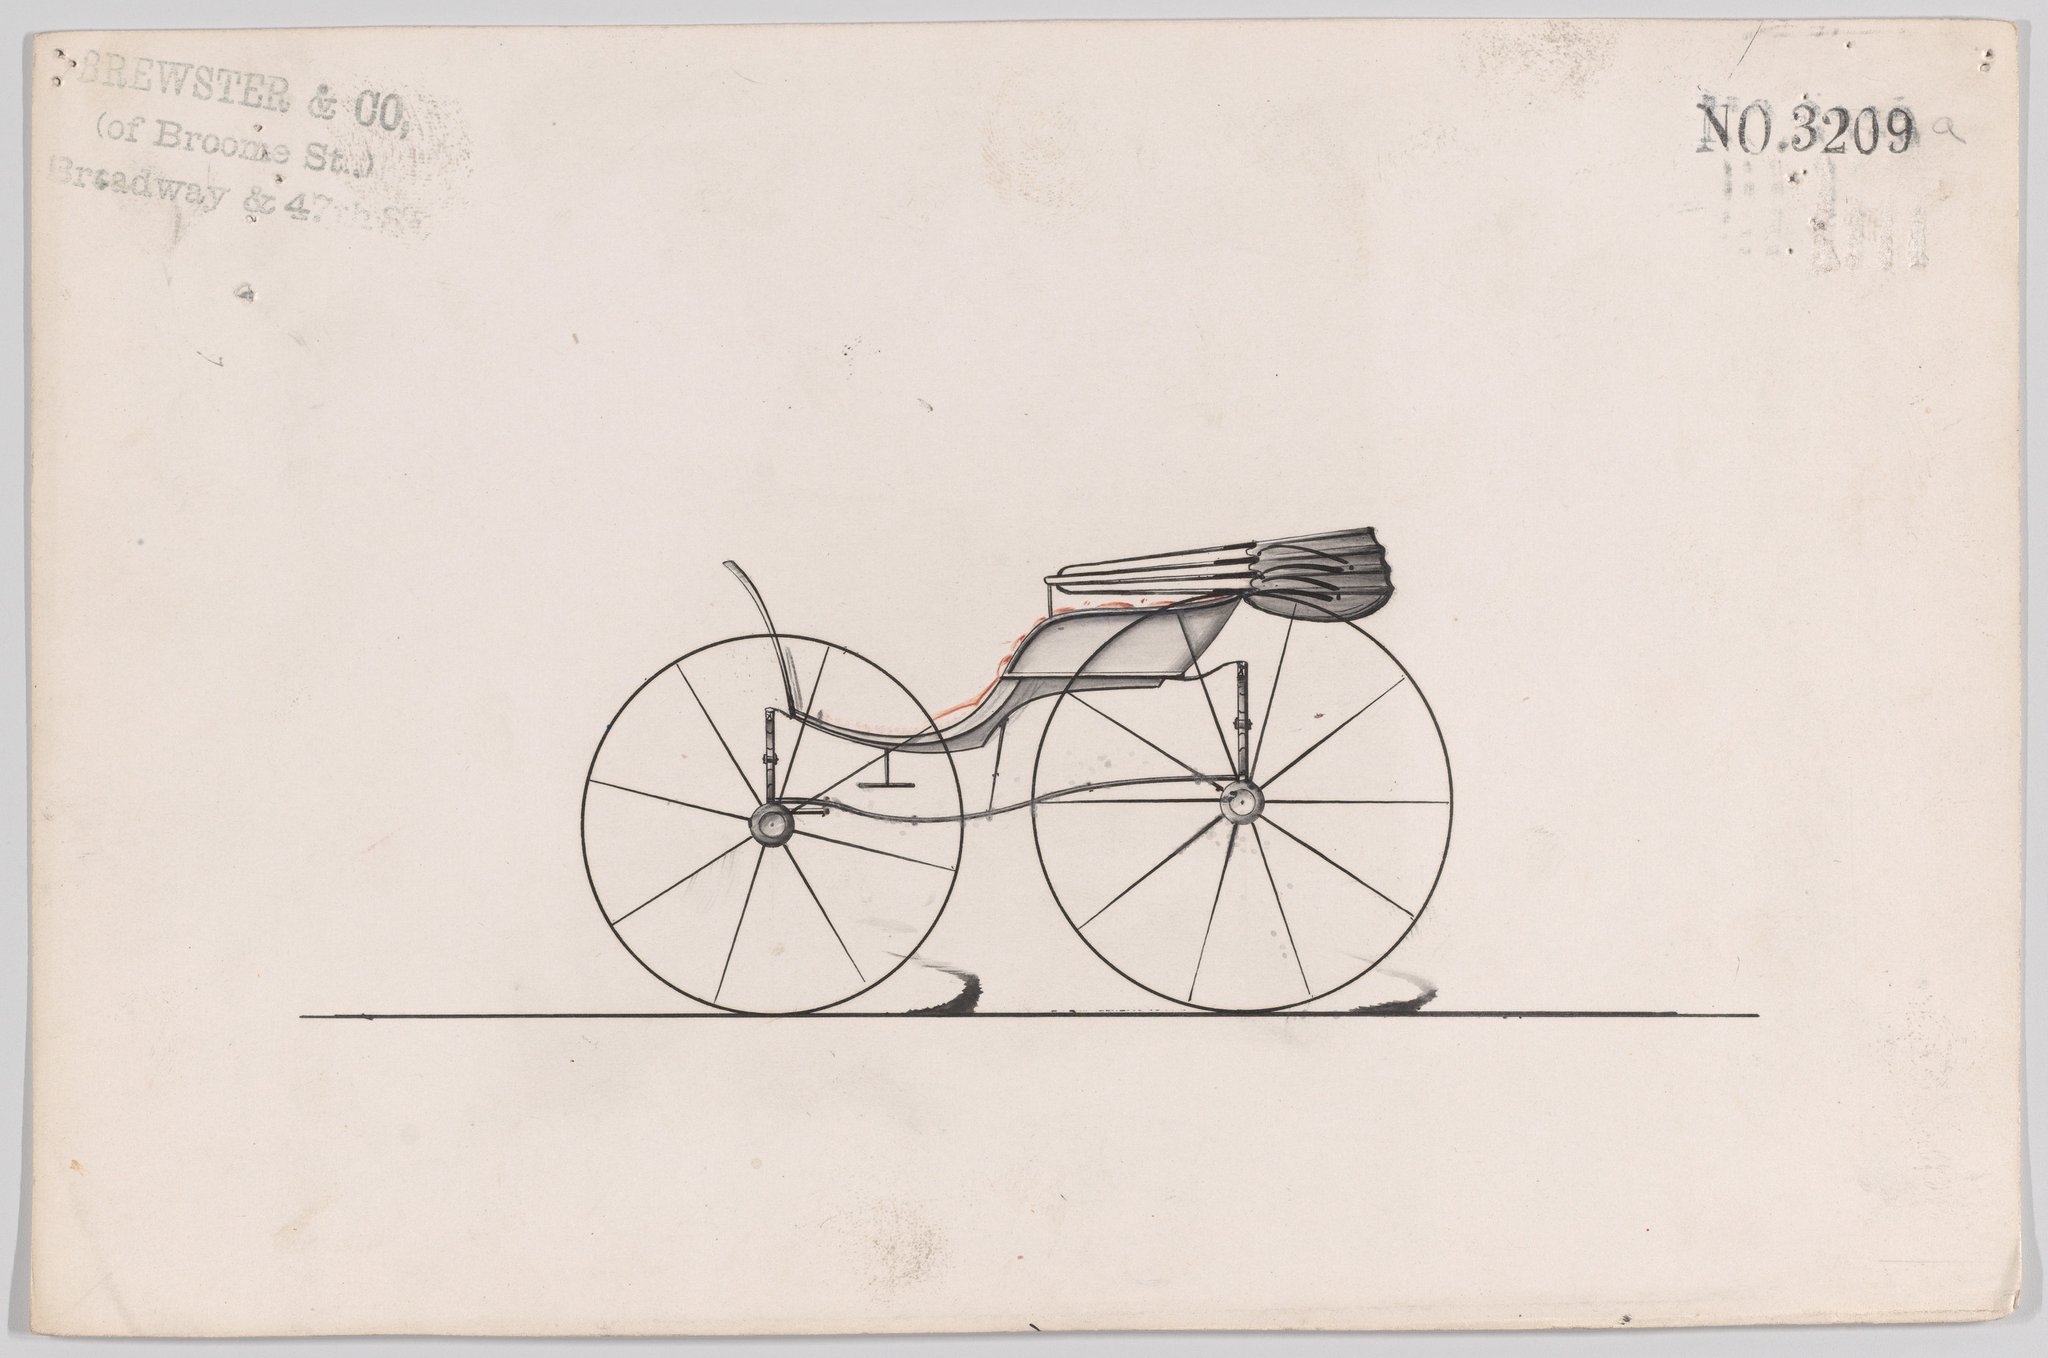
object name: drawing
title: Design for Pony Phaeton, no. 3209a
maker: brewster & co.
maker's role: manufacturer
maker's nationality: american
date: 1876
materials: gouache, ink, watercolor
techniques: pen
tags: carriages